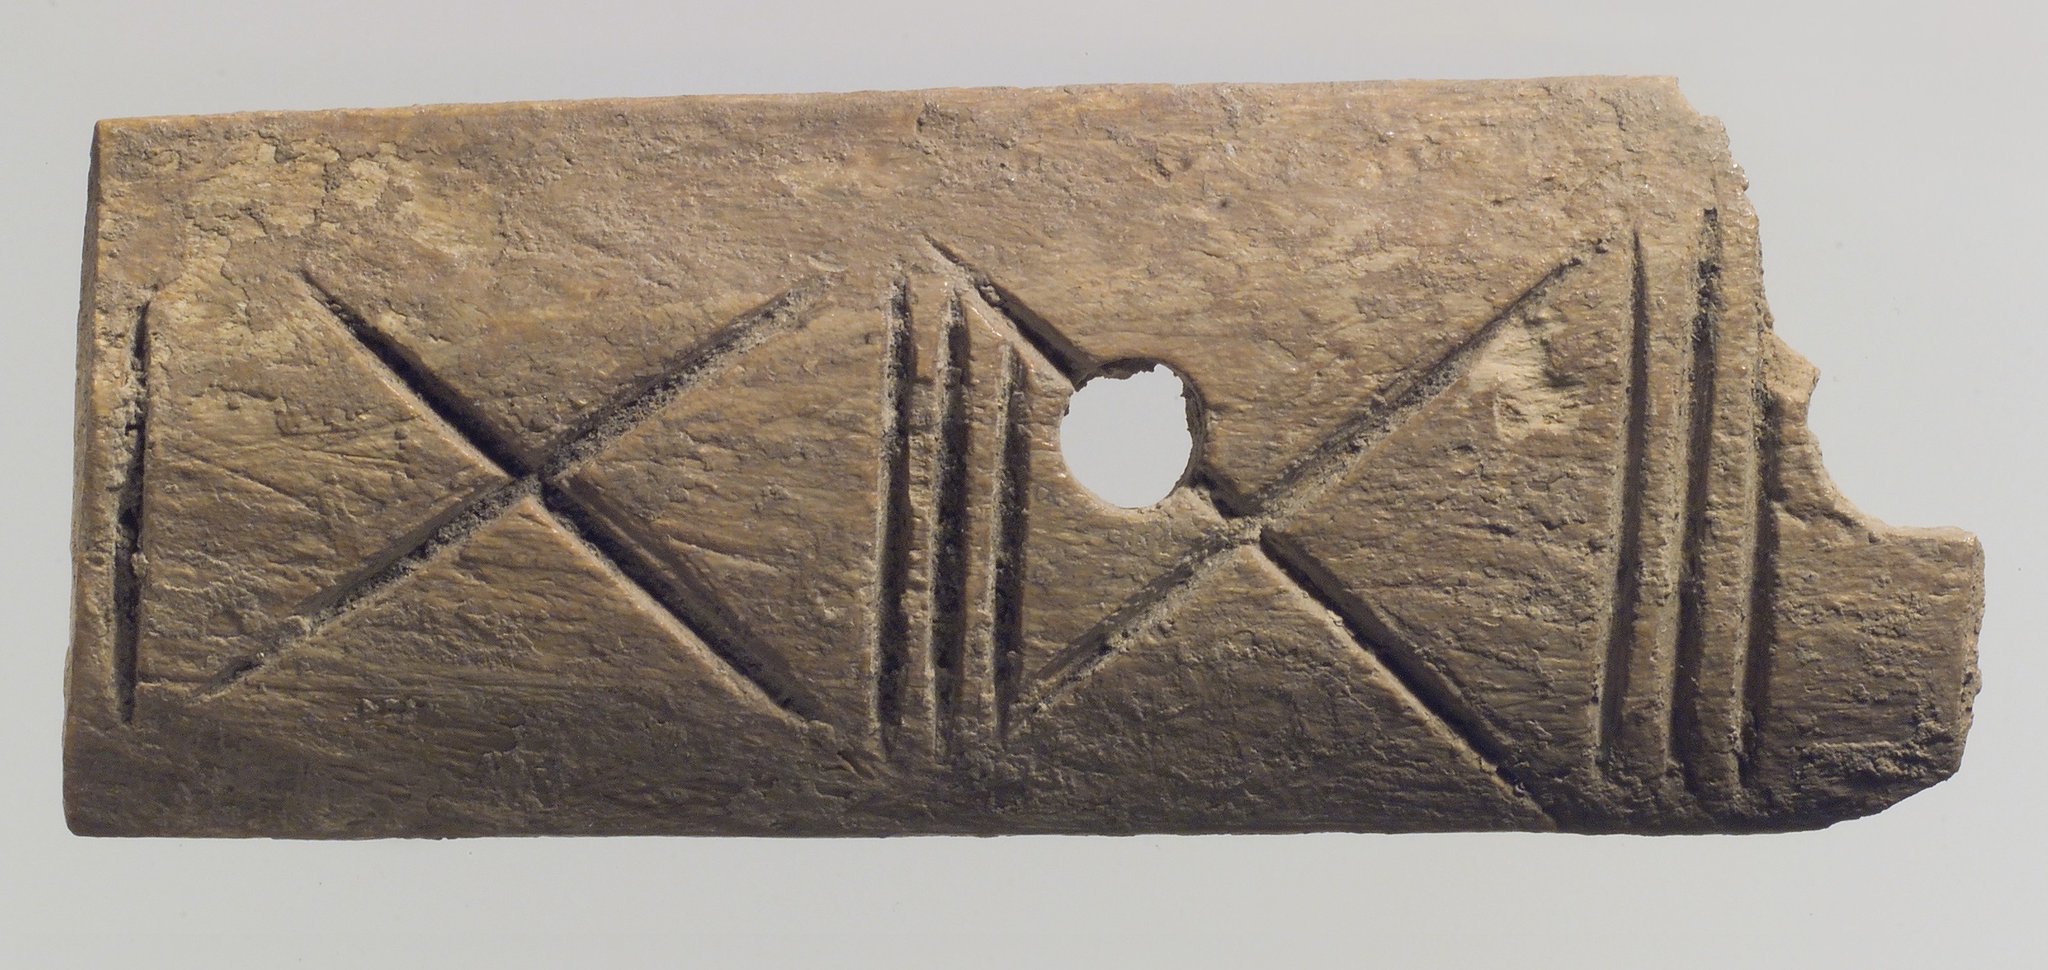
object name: inlay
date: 1780-1580 BCE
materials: bone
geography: levant